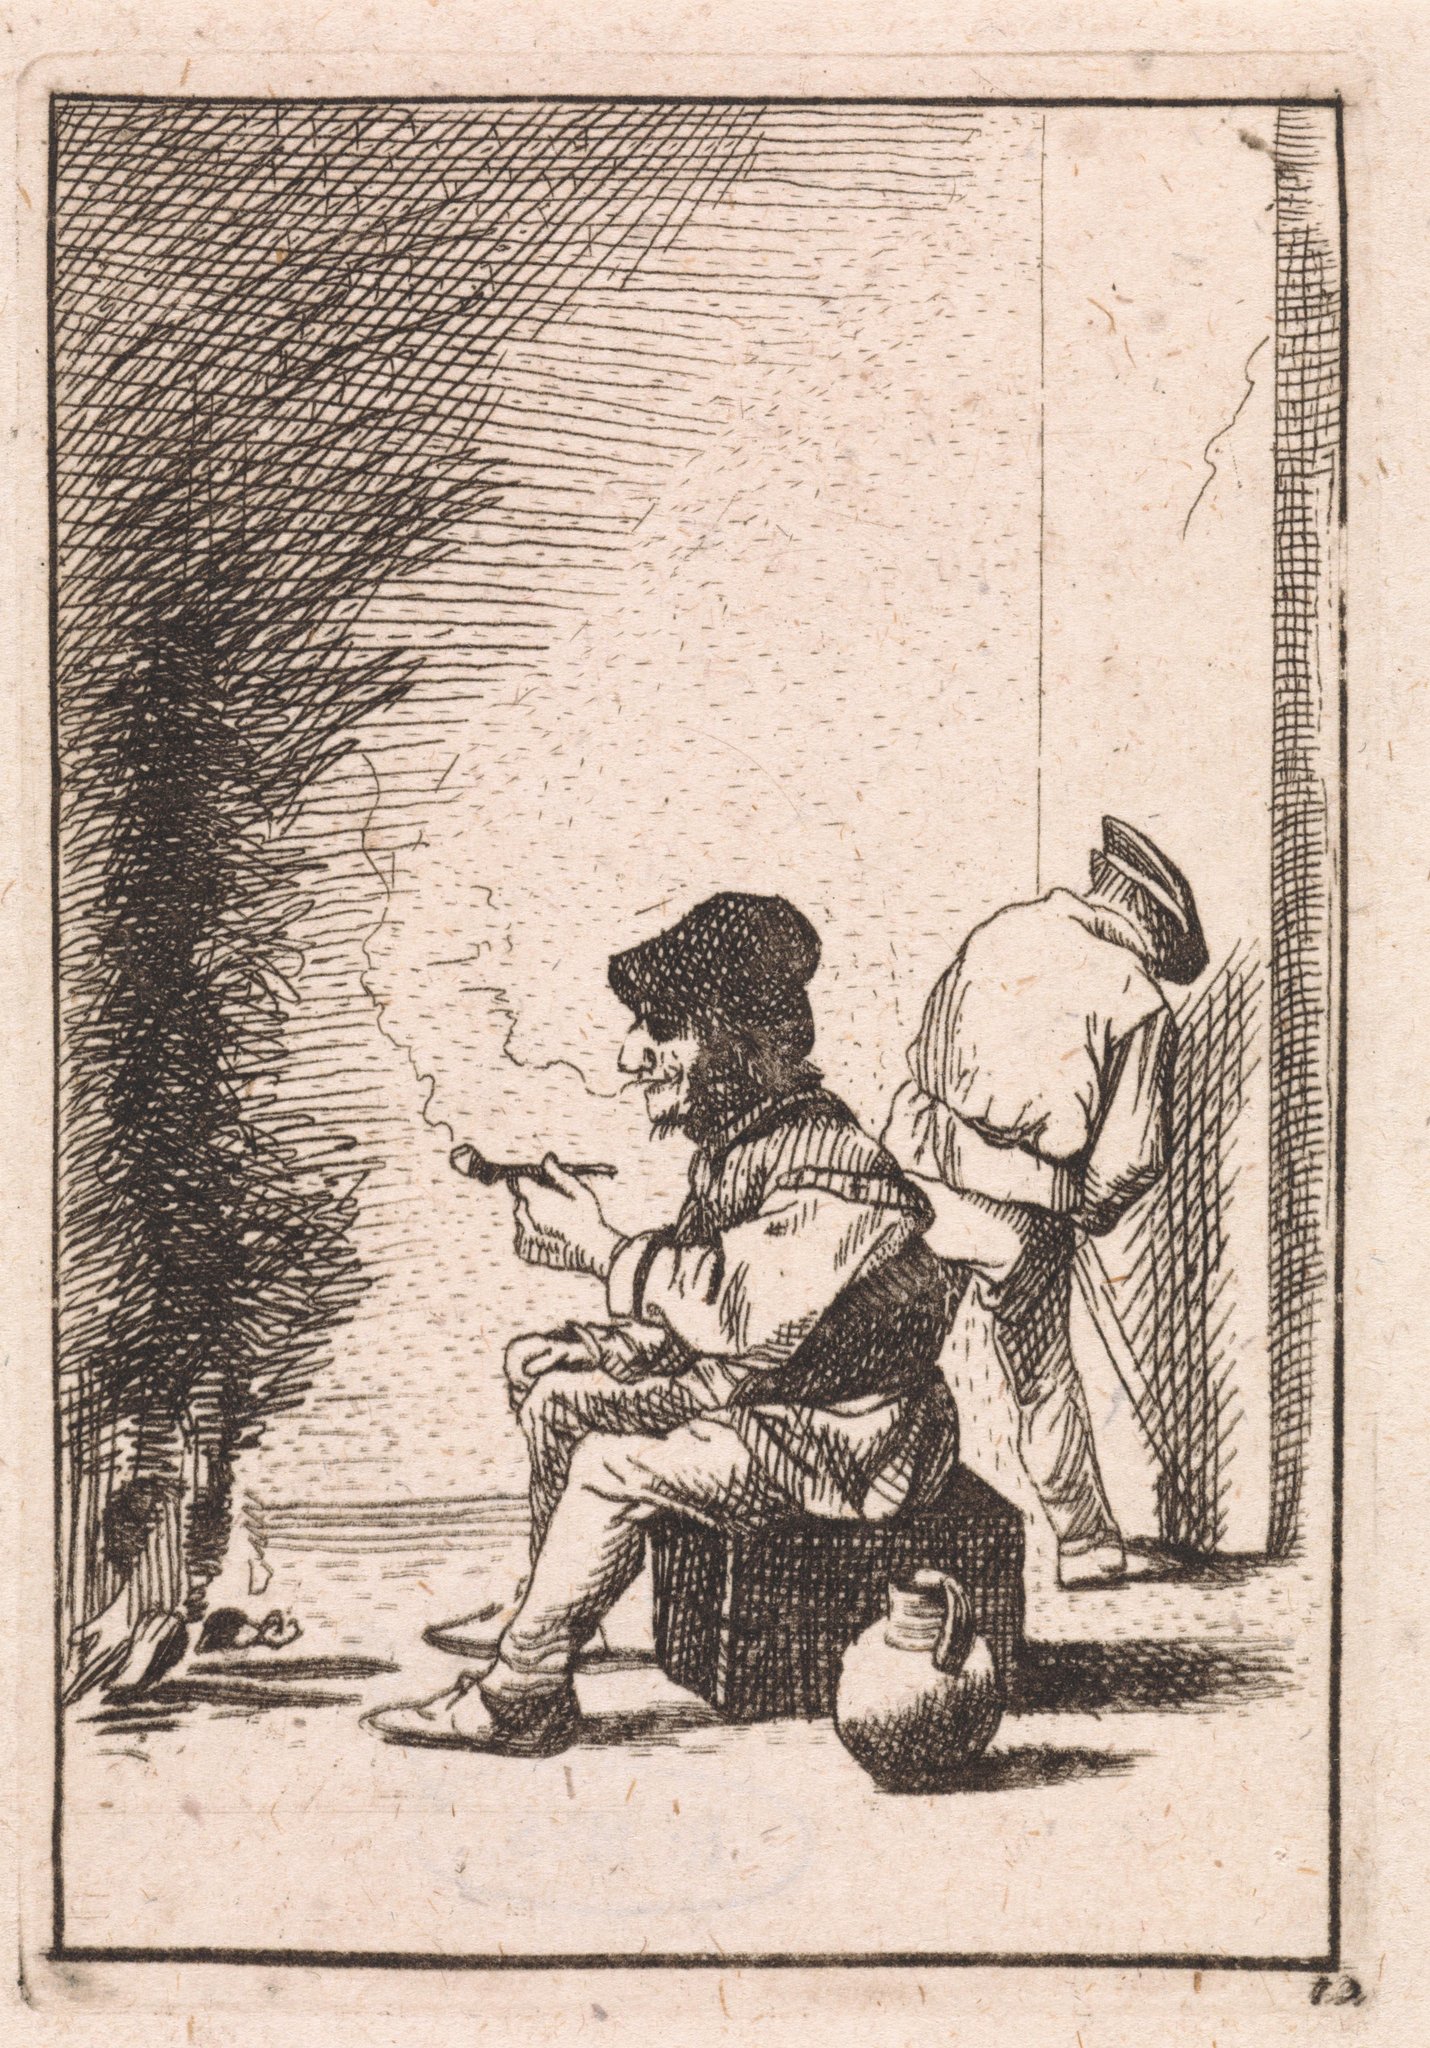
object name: print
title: Rokende boer bij het vuur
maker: Anonymous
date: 1626-1740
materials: paper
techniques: etching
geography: netherlands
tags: pipe ~ tobacco, open hearth, fire-place, urination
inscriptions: collector's mark: Lugt 2228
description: Een boer rookt zijn pijp bij het vuur. Rechts urineert een man in de hoek.